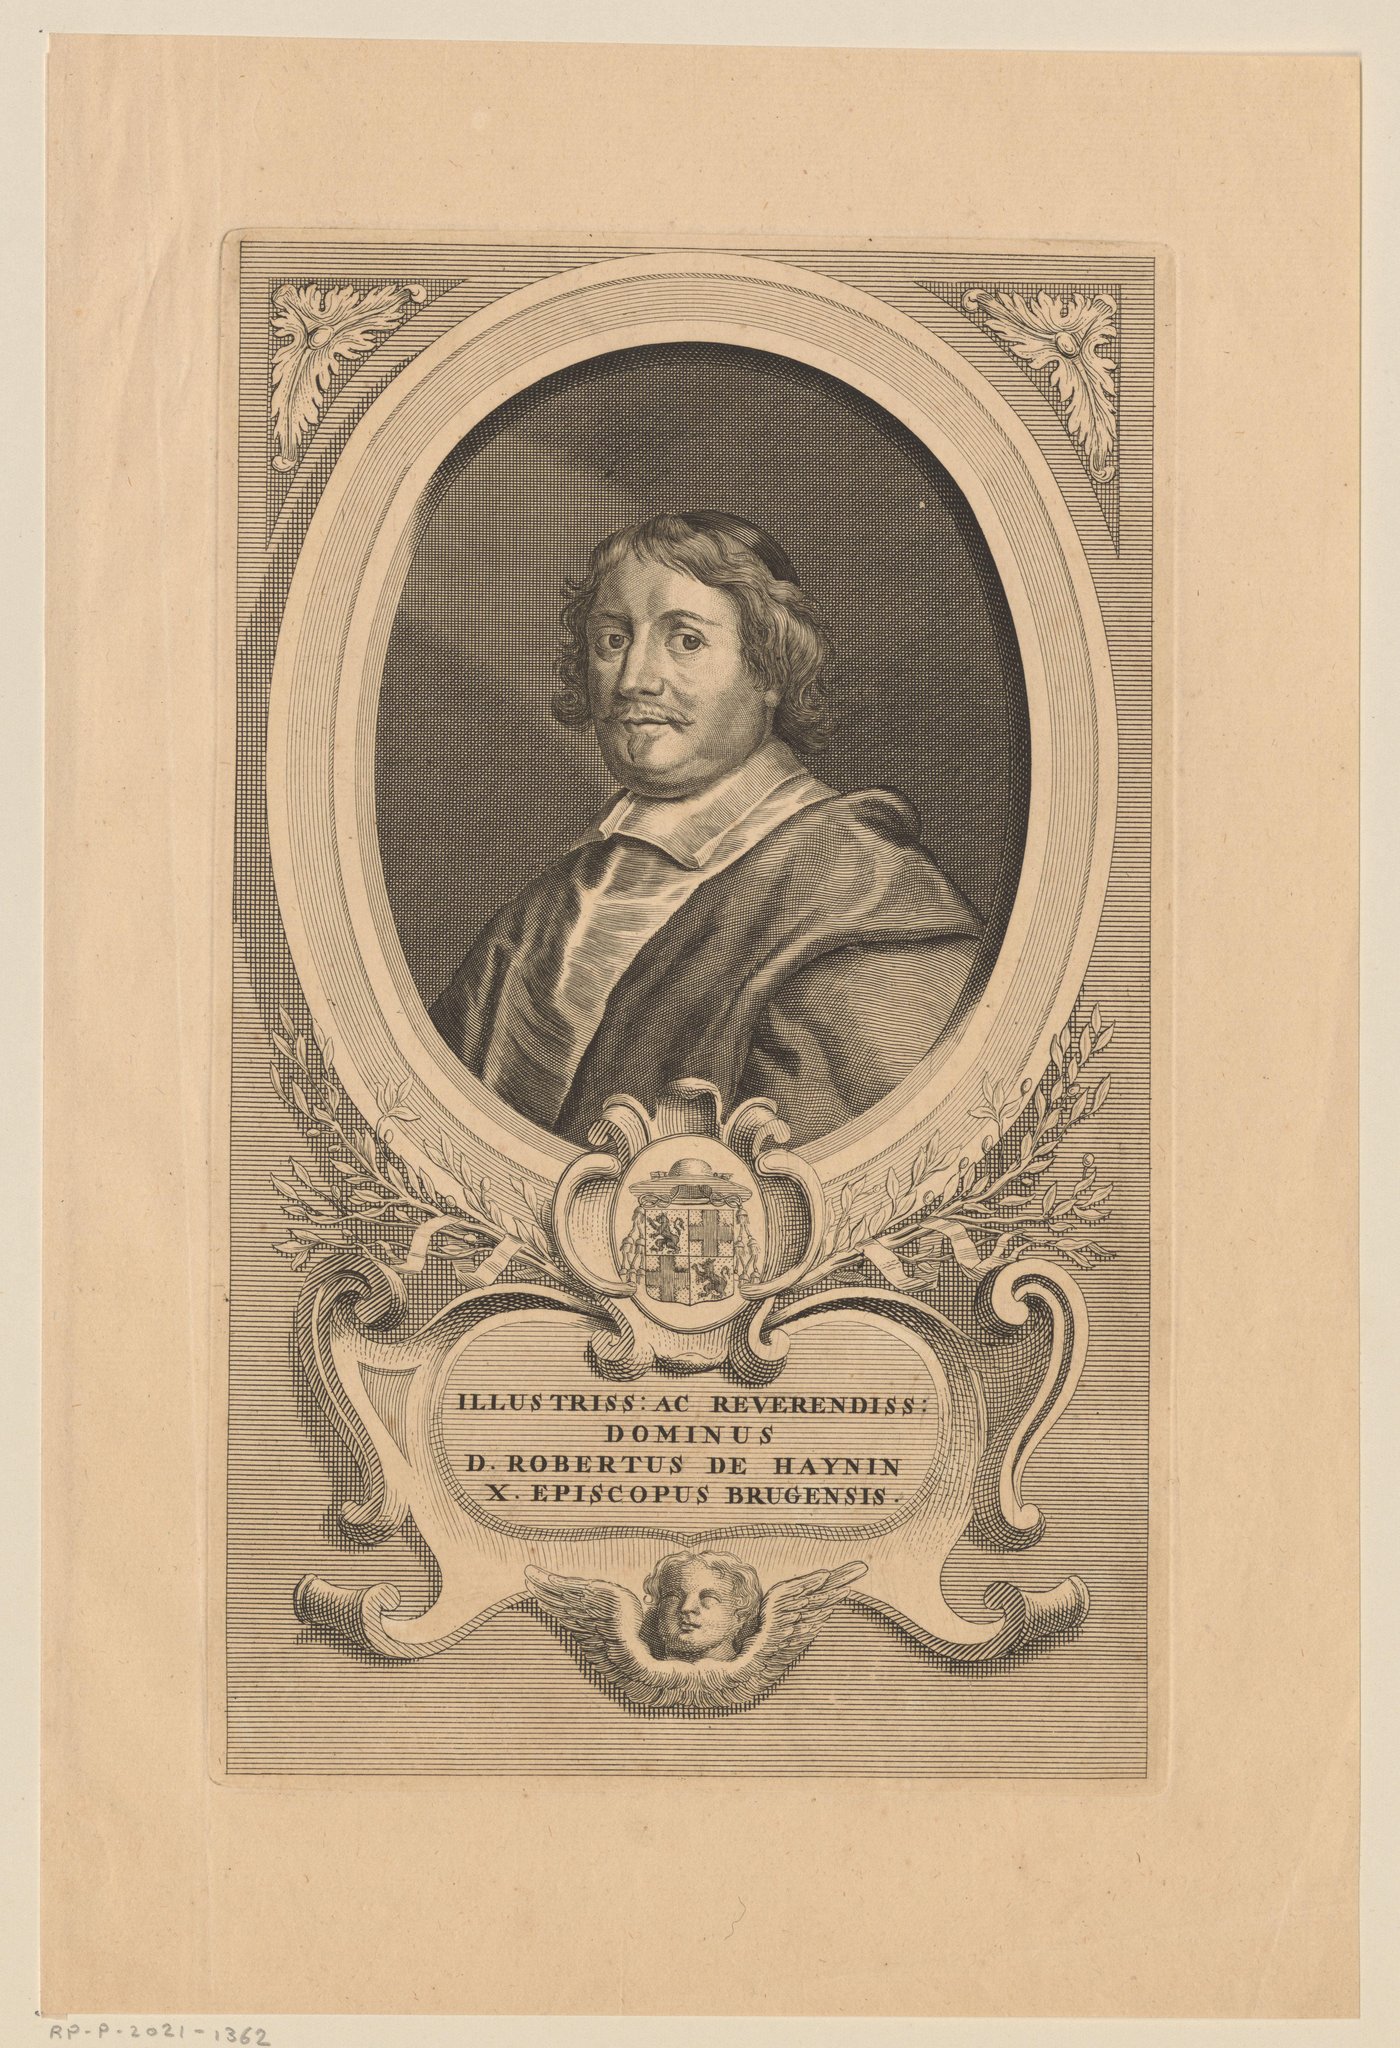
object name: print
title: Portret van Robert de Haynin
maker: Anonymous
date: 1732-1749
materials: paper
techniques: engraving, etching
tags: archbishop, bishop, etc. (roman catholic), historical persons, armorial bearing, heraldry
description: Prent gebruikt in: Sanderus, Antonius. Flandria illustrata, sive provinciae ac comitatus hujus descriptio. Den Haag: Christiaan van Lom, 1732. Prent ook gebruikt in de Latijnse uitgave van 1735. Prent mogelijk ook gebruikt in andere publicaties.